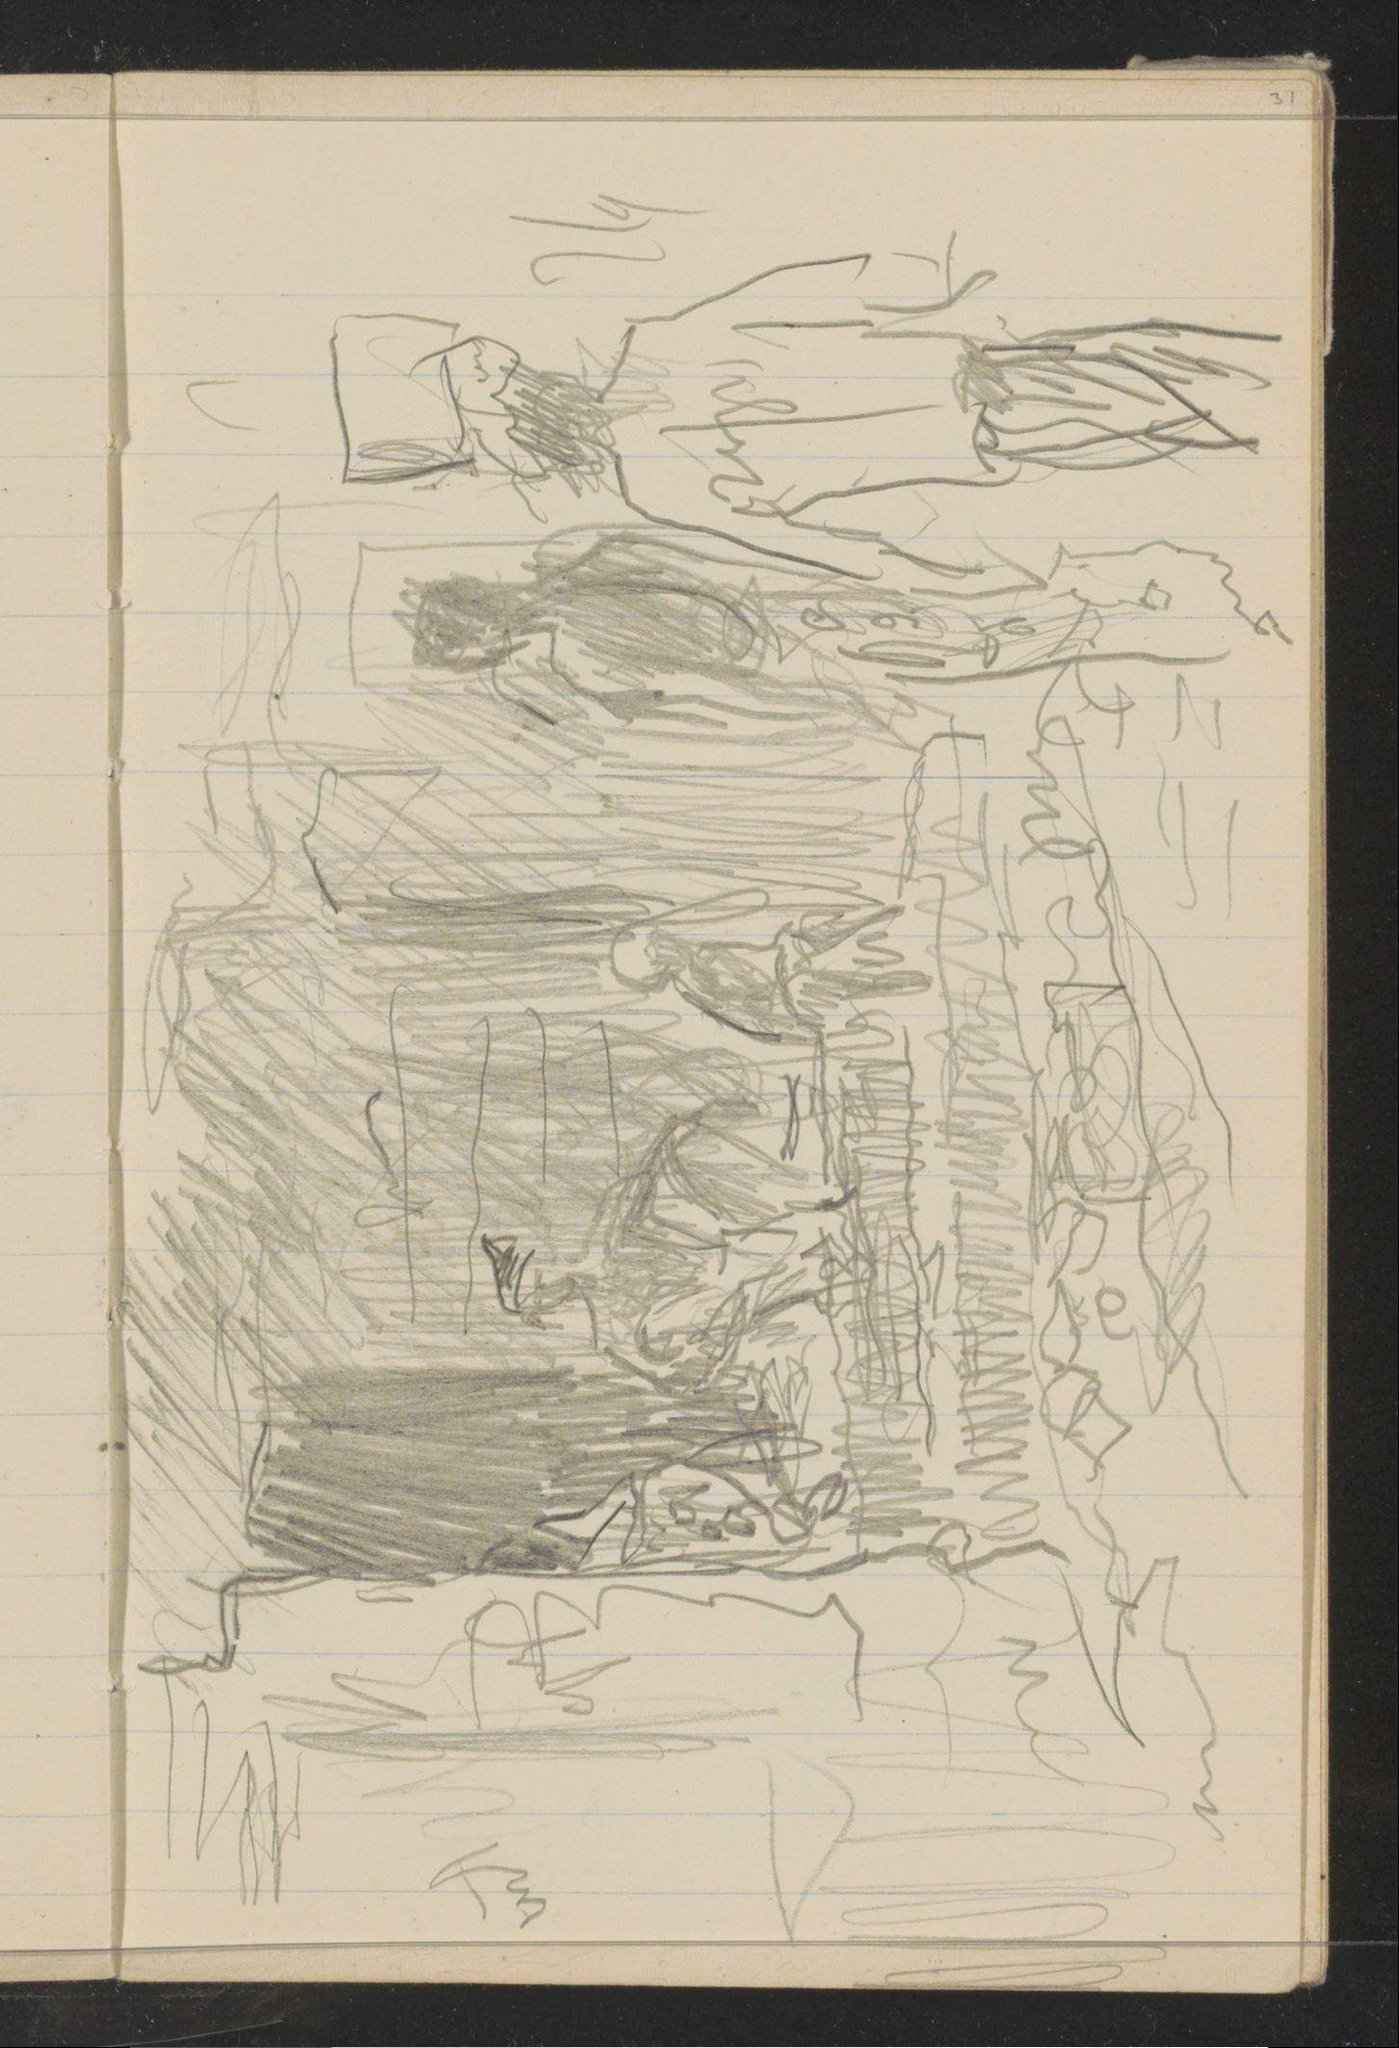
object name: sketchbook leaf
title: Straat met zittende figuren op een trap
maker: marius bauer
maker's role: draughtsman, print maker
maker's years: 1867-1932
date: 1931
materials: pencil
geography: java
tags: sitting figure, flight of steps, street (+ city(-scape) with figures, staffage)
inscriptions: annotation: ‘2/4’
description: Pagina 31 uit een schetsboek met 74 bladen.